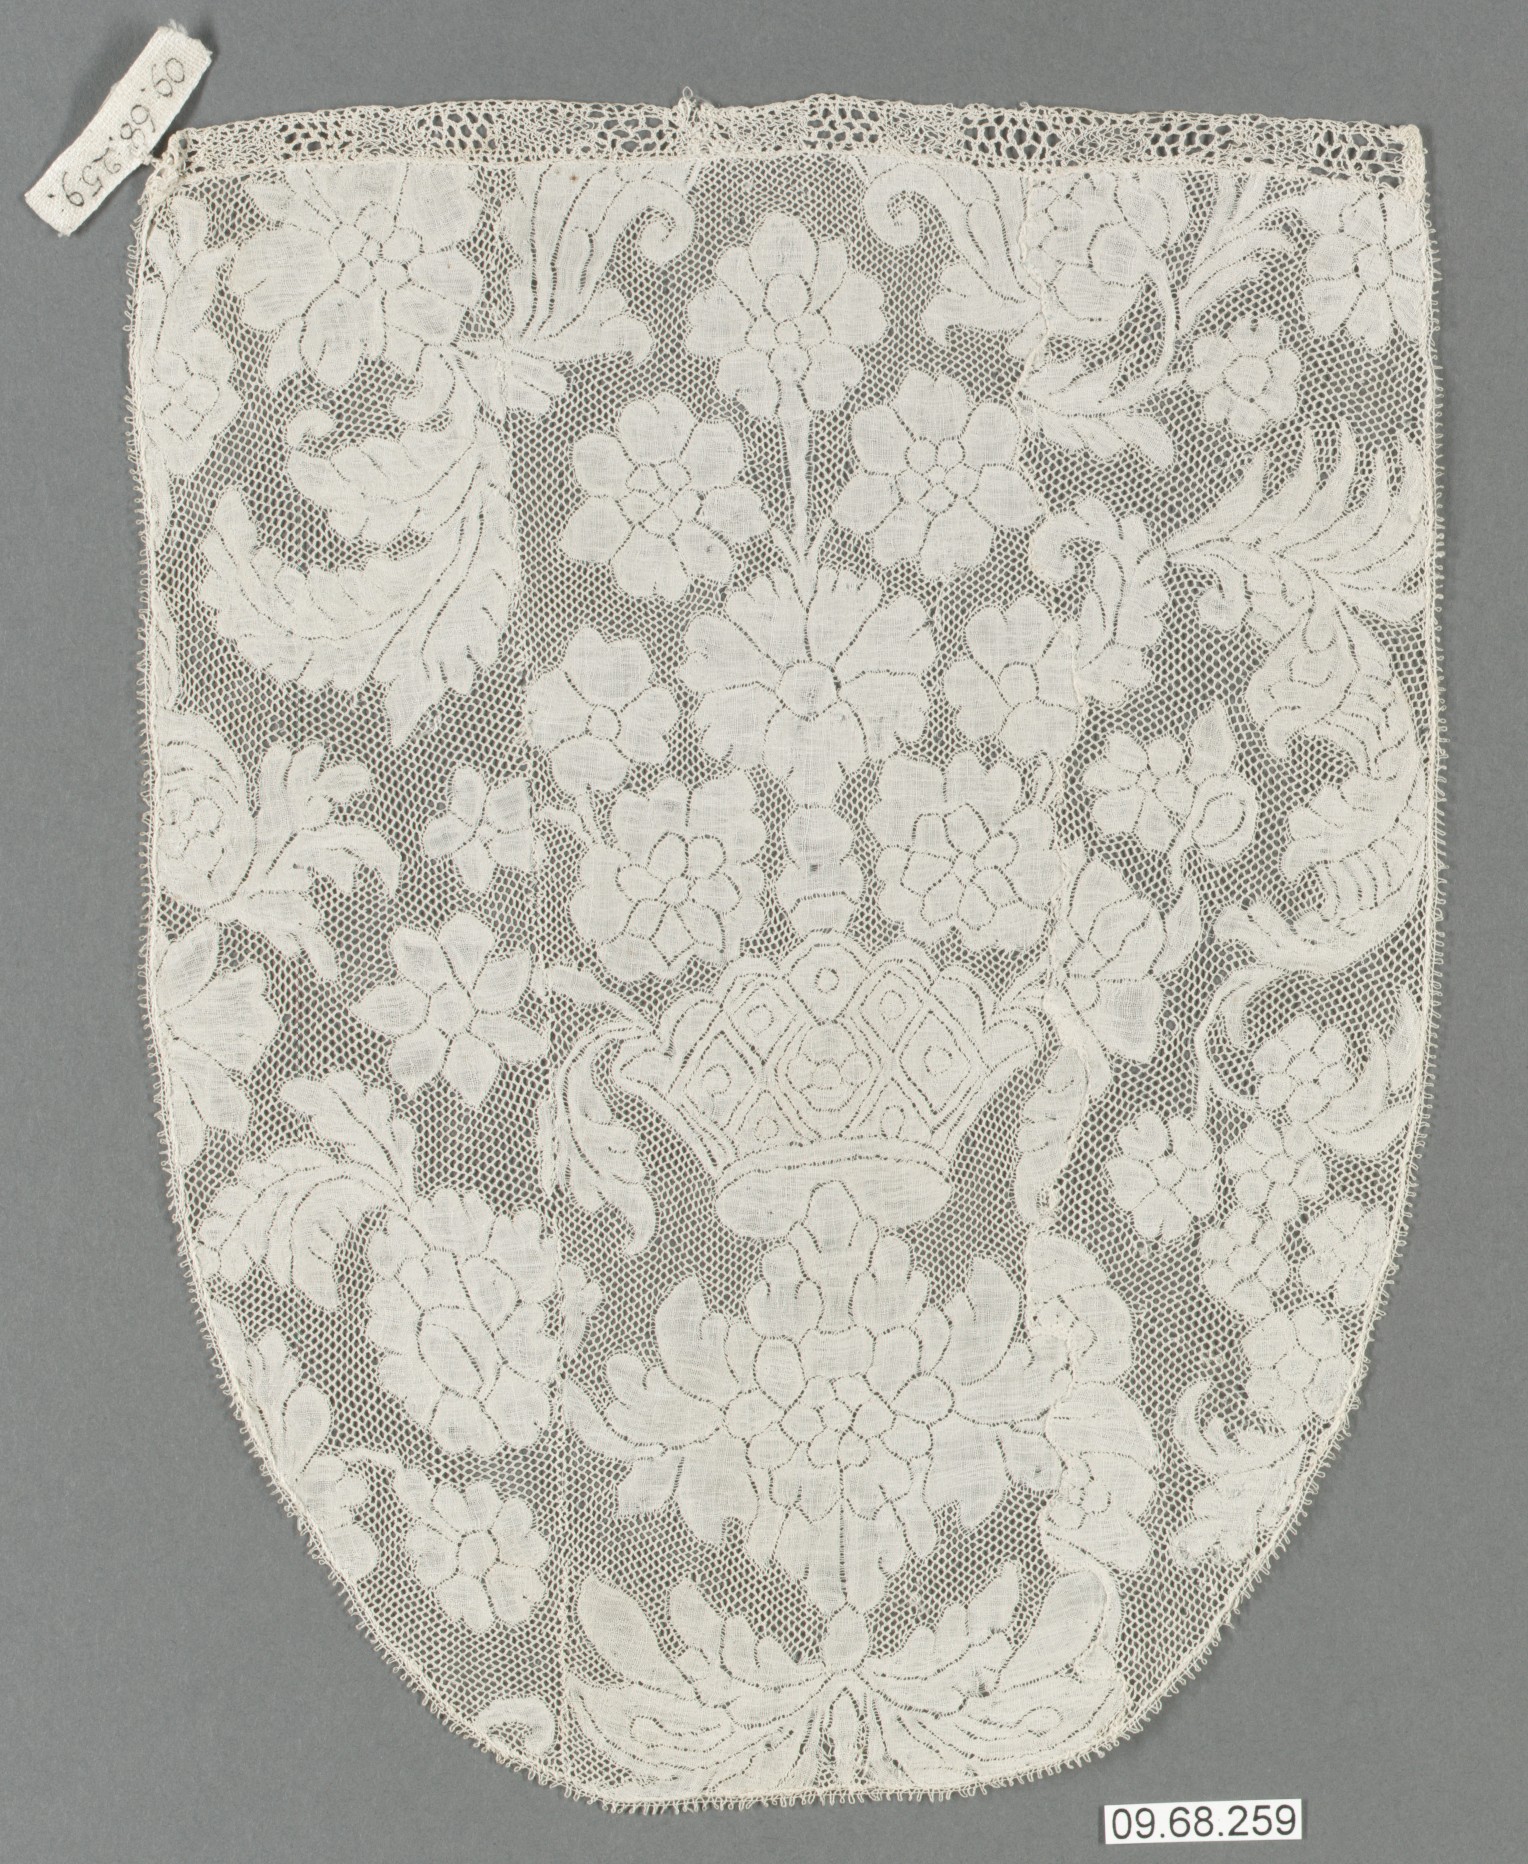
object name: piece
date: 1701-1733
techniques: lace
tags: flowers,leaves